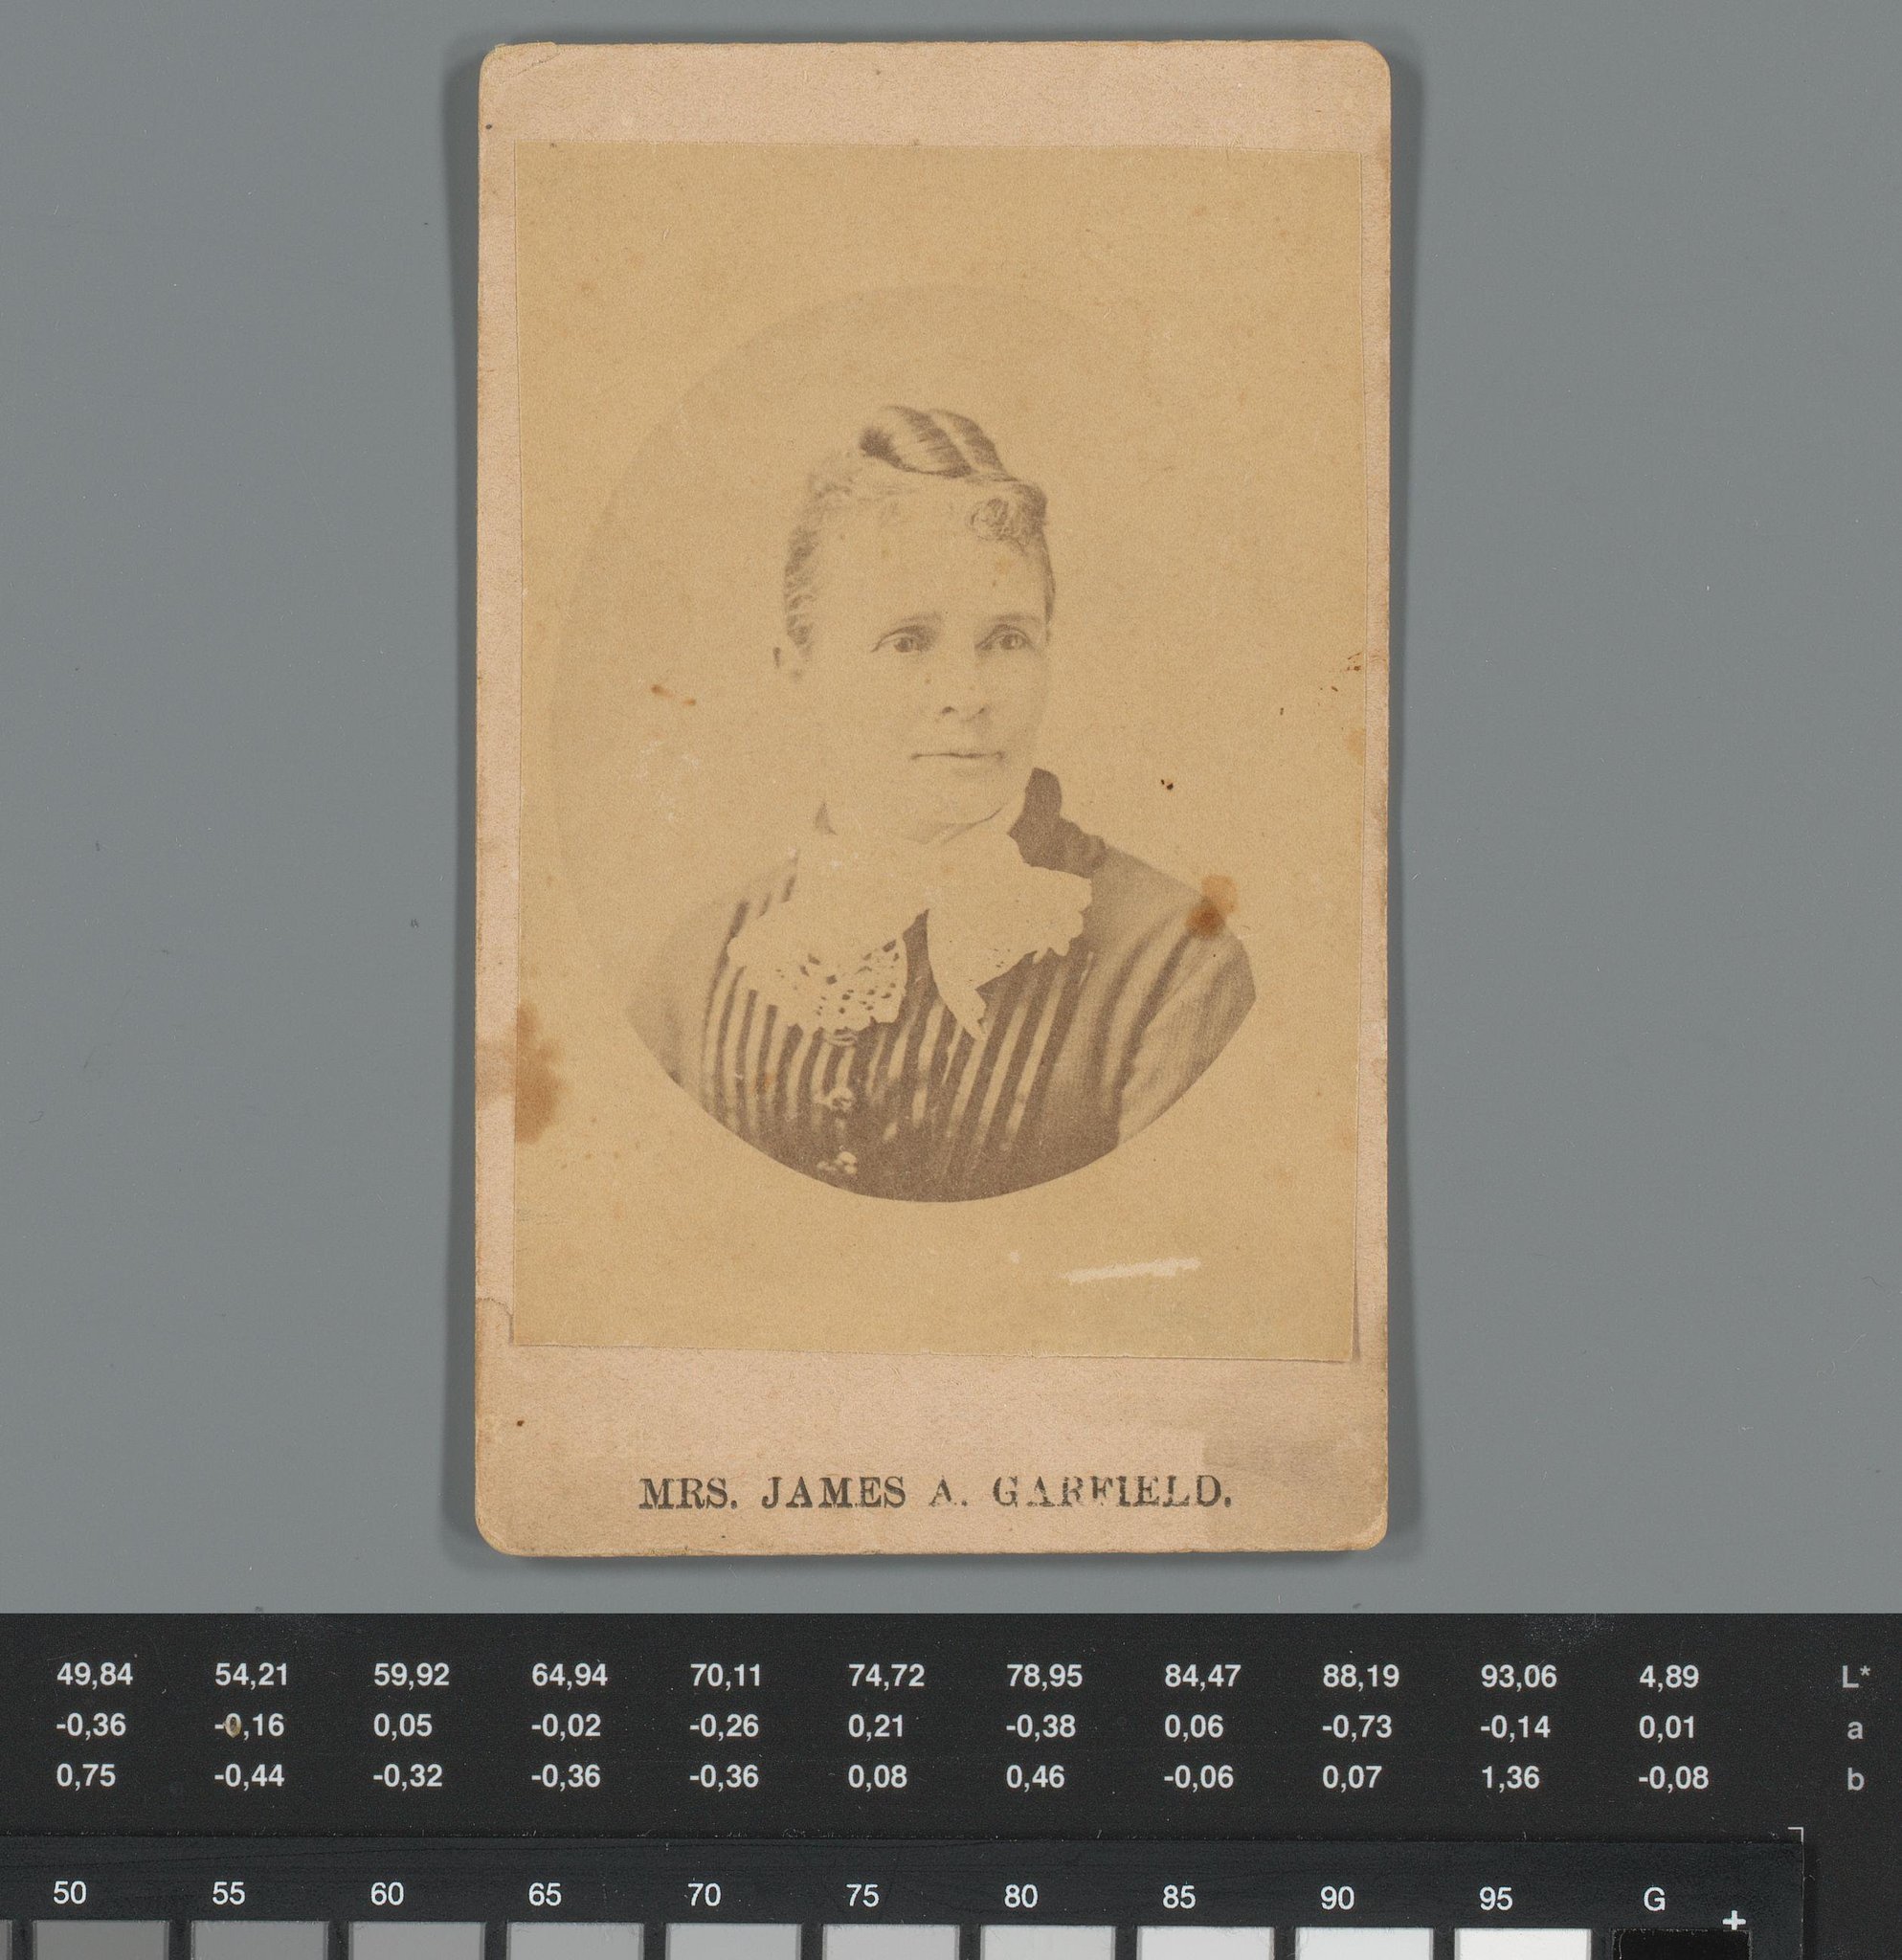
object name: carte de visite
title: Mrs. James A. Garfield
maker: Anonymous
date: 1850-1915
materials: cardboard, photographic support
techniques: albumen print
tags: advertising, historical persons - bb - woman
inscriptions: inscription: ‘(...)’